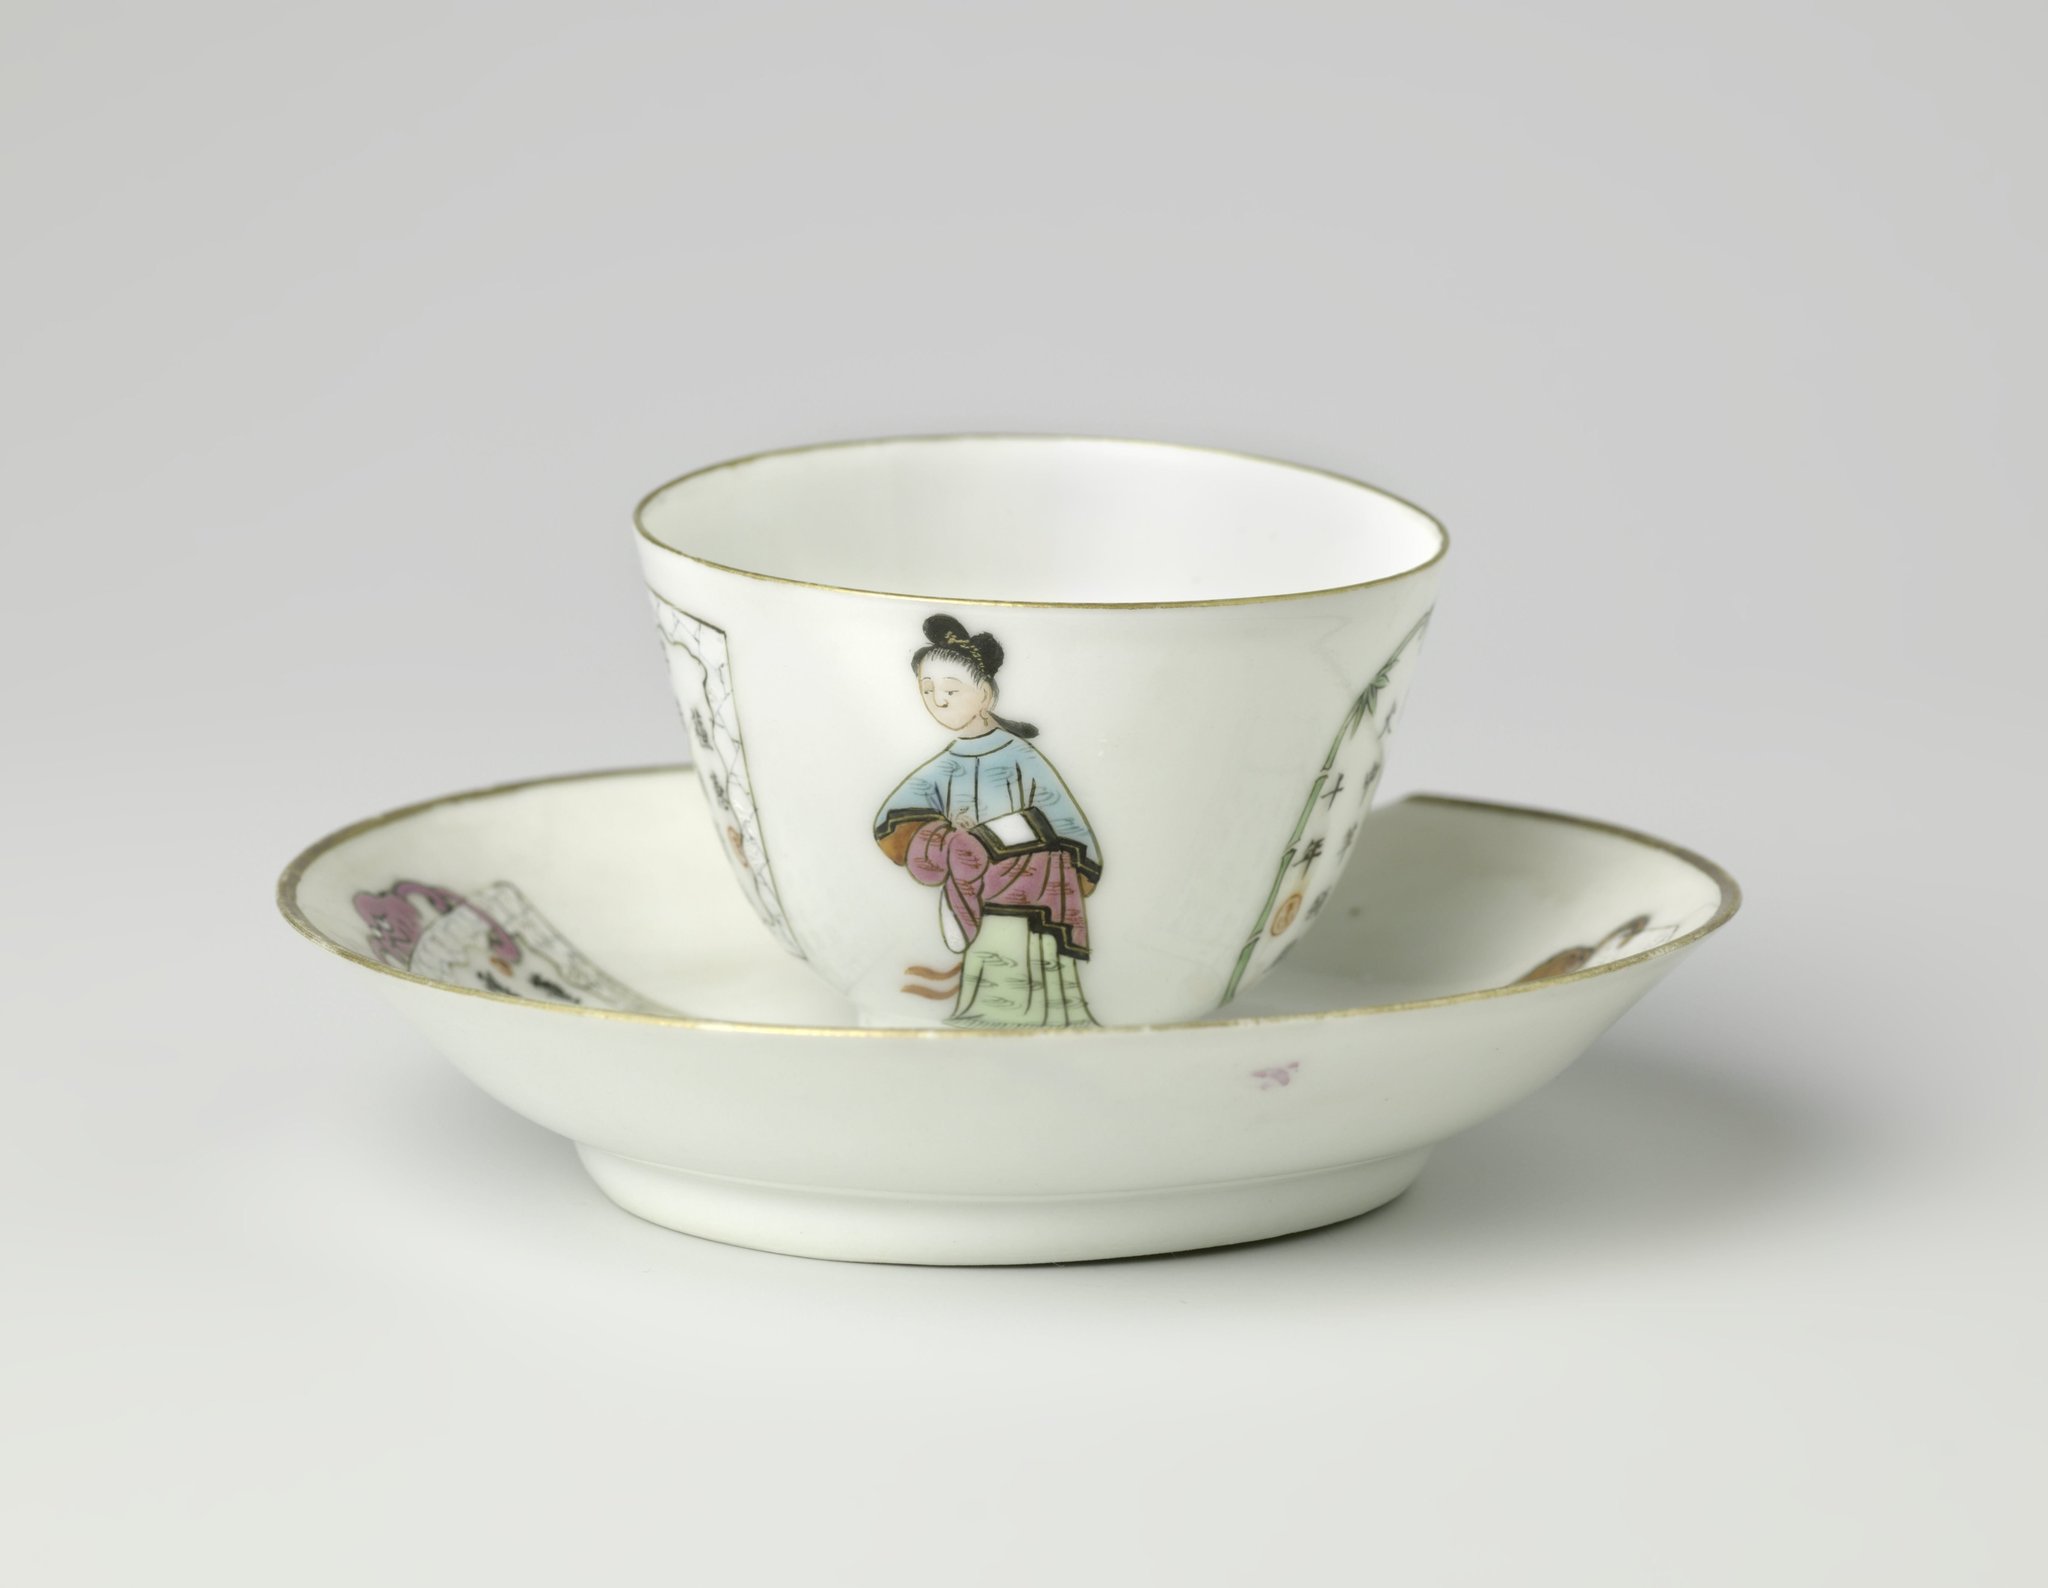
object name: kop en schotel, kop en schotel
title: Cup and saucer with a man, woman and two panels with characters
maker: Anonymous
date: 1825-1874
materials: glaze, gold, paint, porcelain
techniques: firing, gilding, turning, vitrification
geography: china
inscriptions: inscription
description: Kop en schotel, met figuren in polychroom email kleuren.